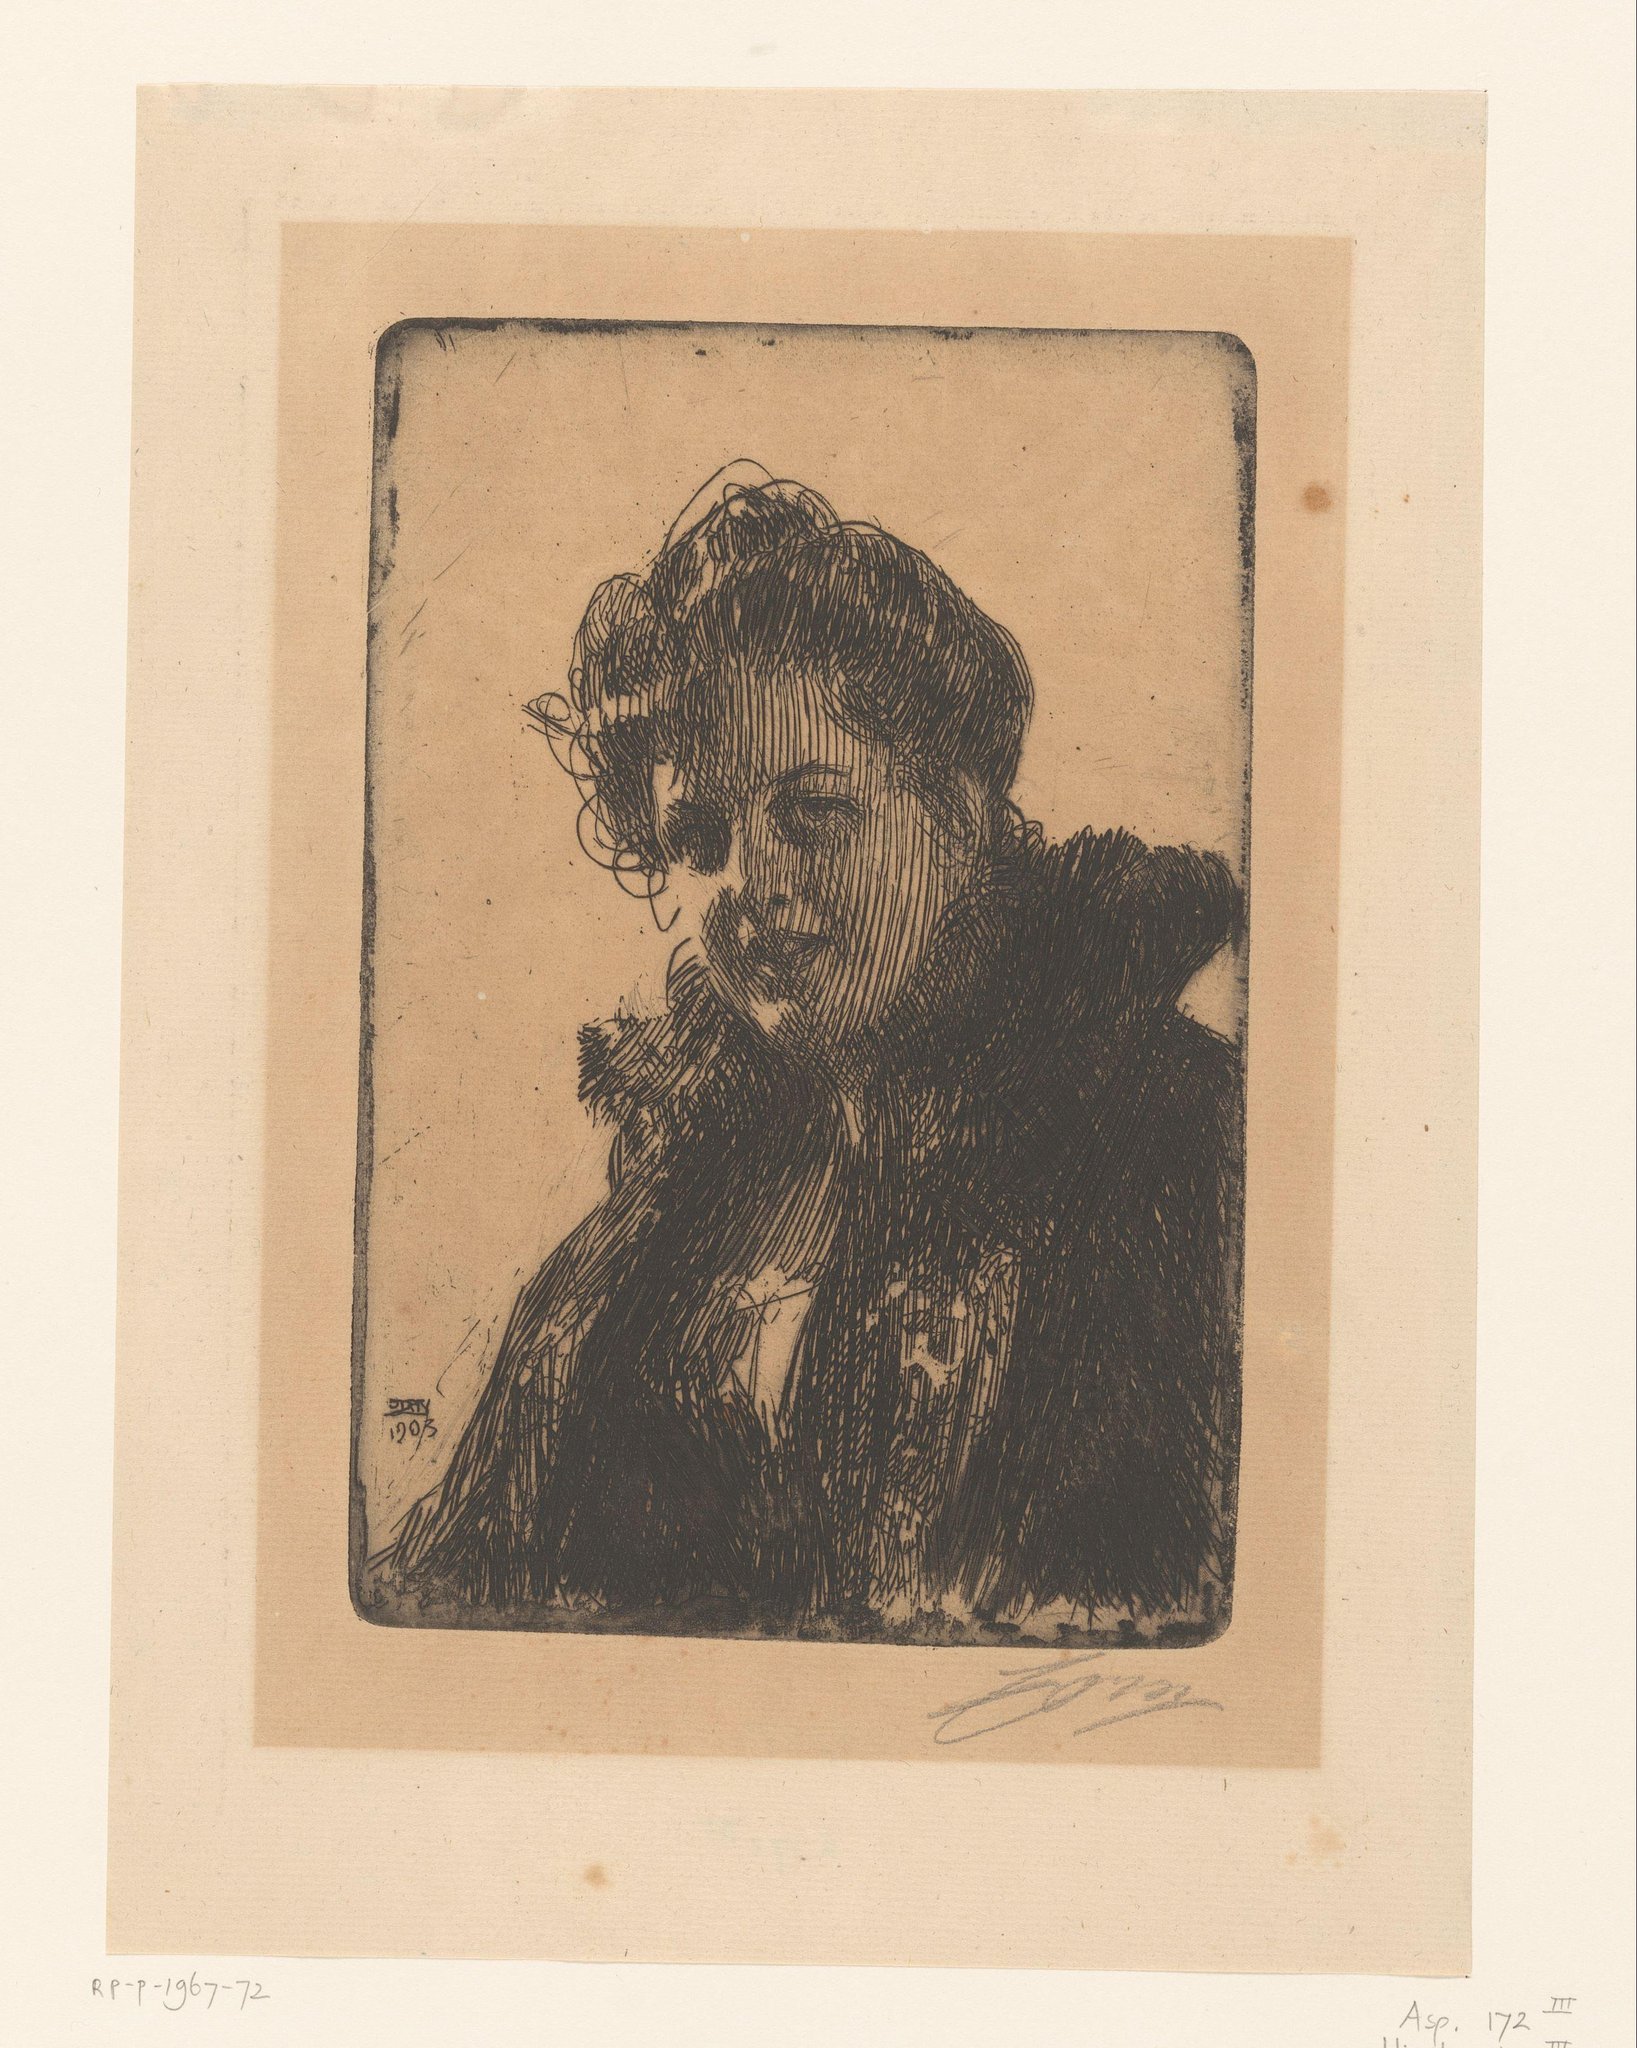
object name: print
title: Portret van Amalia Granberg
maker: anders leonard zorn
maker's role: print maker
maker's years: 1860-1920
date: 1903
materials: paper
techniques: etching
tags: historical persons - bb - woman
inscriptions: collector's mark: Lugt 2228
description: Portret van Amalia Granberg, buste iets naar links, met hoge kraag.